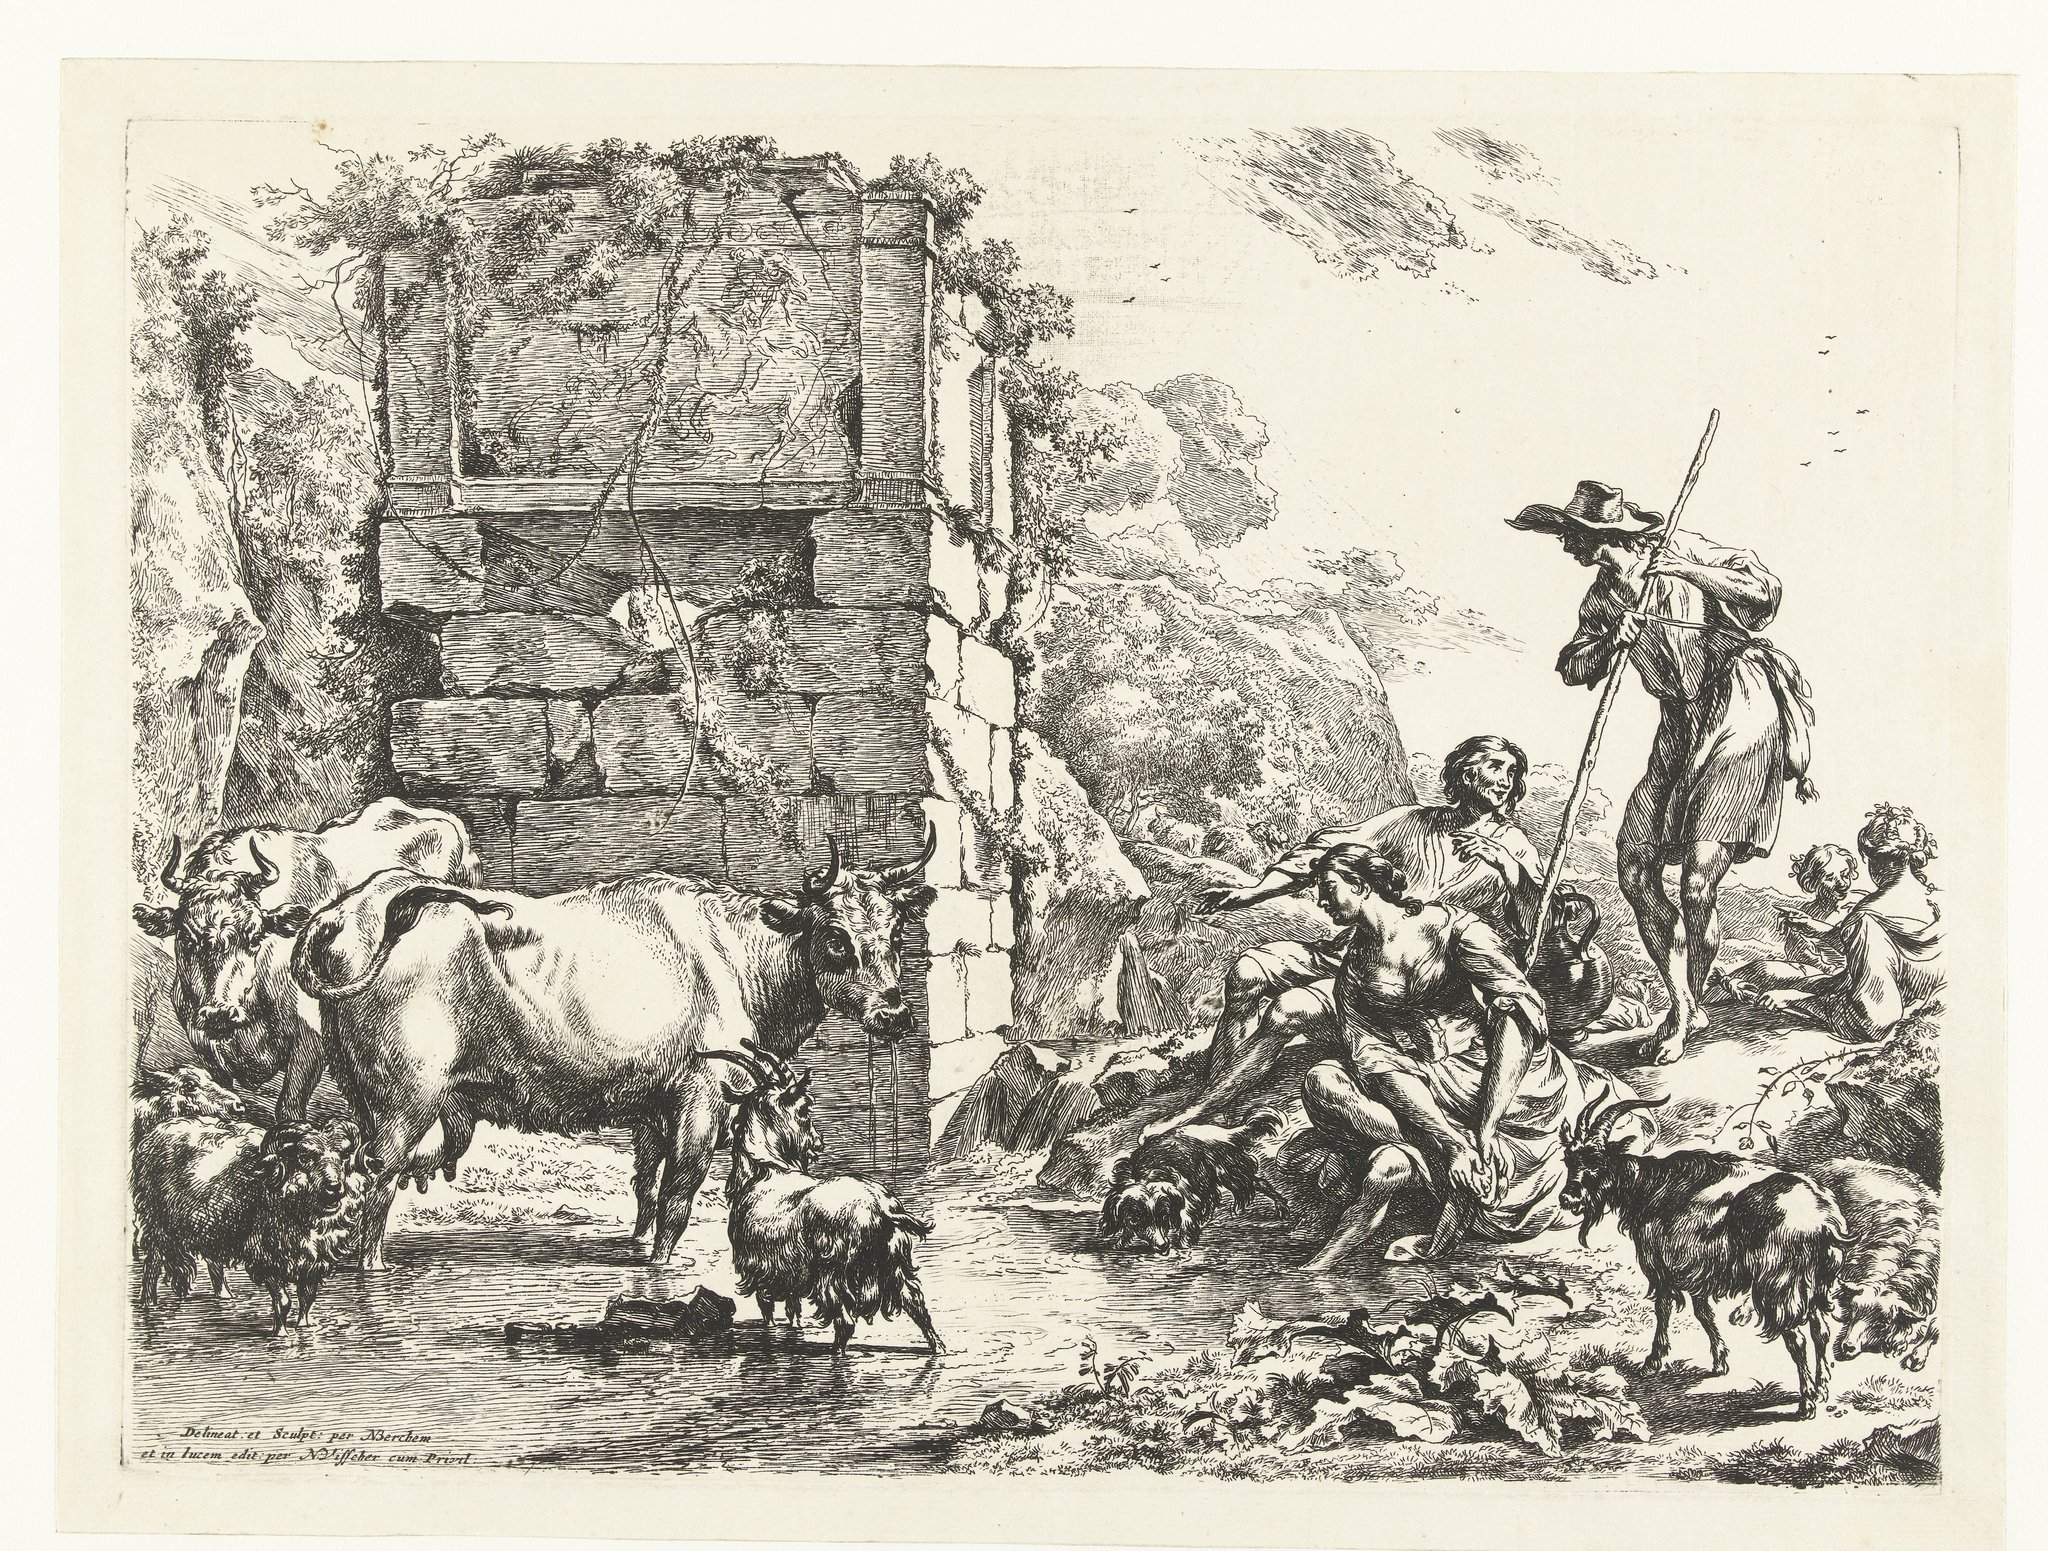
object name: print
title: Drinkende koe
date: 1680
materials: paper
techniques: etching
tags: cow, herding, herdsman, herdswoman, shepherd, shepherdess, cowherd, etc.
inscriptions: collector's mark: Lugt 240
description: Herders en herderinnen rusten met hun vee bij een beek in een rotslandschap. Twee koeien, een geit en twee schapen staan in ondiep water voor een vervallen monument met een reliëf. De titel dankt de prent aan de koe met de snuit waar het water van afdruipt.